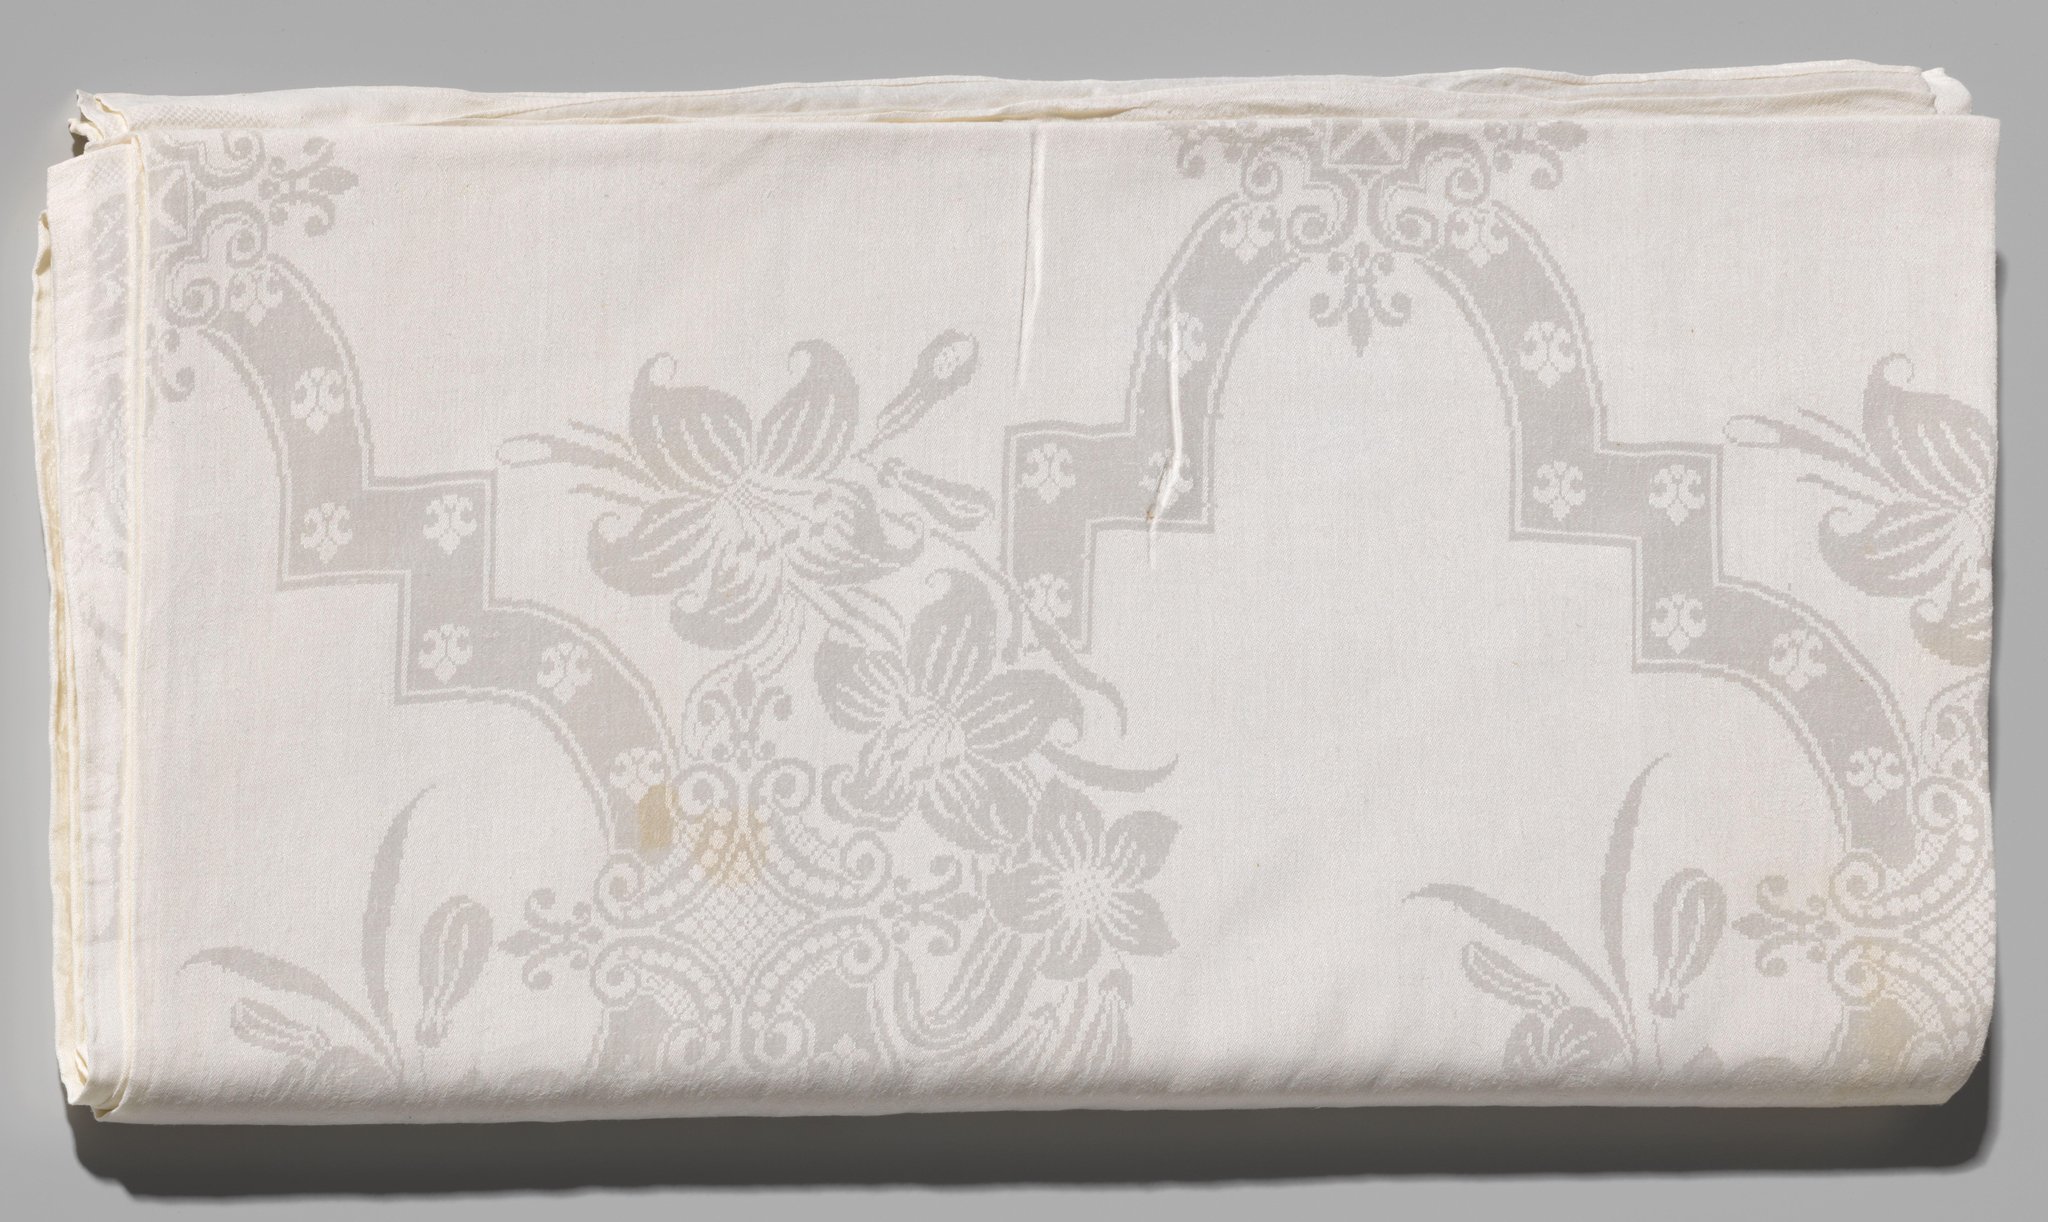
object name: tablecloth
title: Tafellaken met fleurs de lys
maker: Anonymous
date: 1700-1710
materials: linen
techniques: damask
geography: dresden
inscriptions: mark: ‘24’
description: Tafellaken van linnendamast met fleurs de lys. Slingerende banden vormen in de hoogte gerekte velden. De banden bestaan uit rechte en ronde delen, gevuld met kleine fleurs de lys; op de raakpunten een slingerende tak met leliën. De rand, alleen aan de buitenzijde omlijnd met fijne zigzagzomen en rolwerk met rastervulling, vertoont dicht aaneengesloten bloemboeketten, in de hoeken naar het midden gericht en voortkomend uit een draagstuk, waarop een fleur de lys. Rondom: blokkenrand.